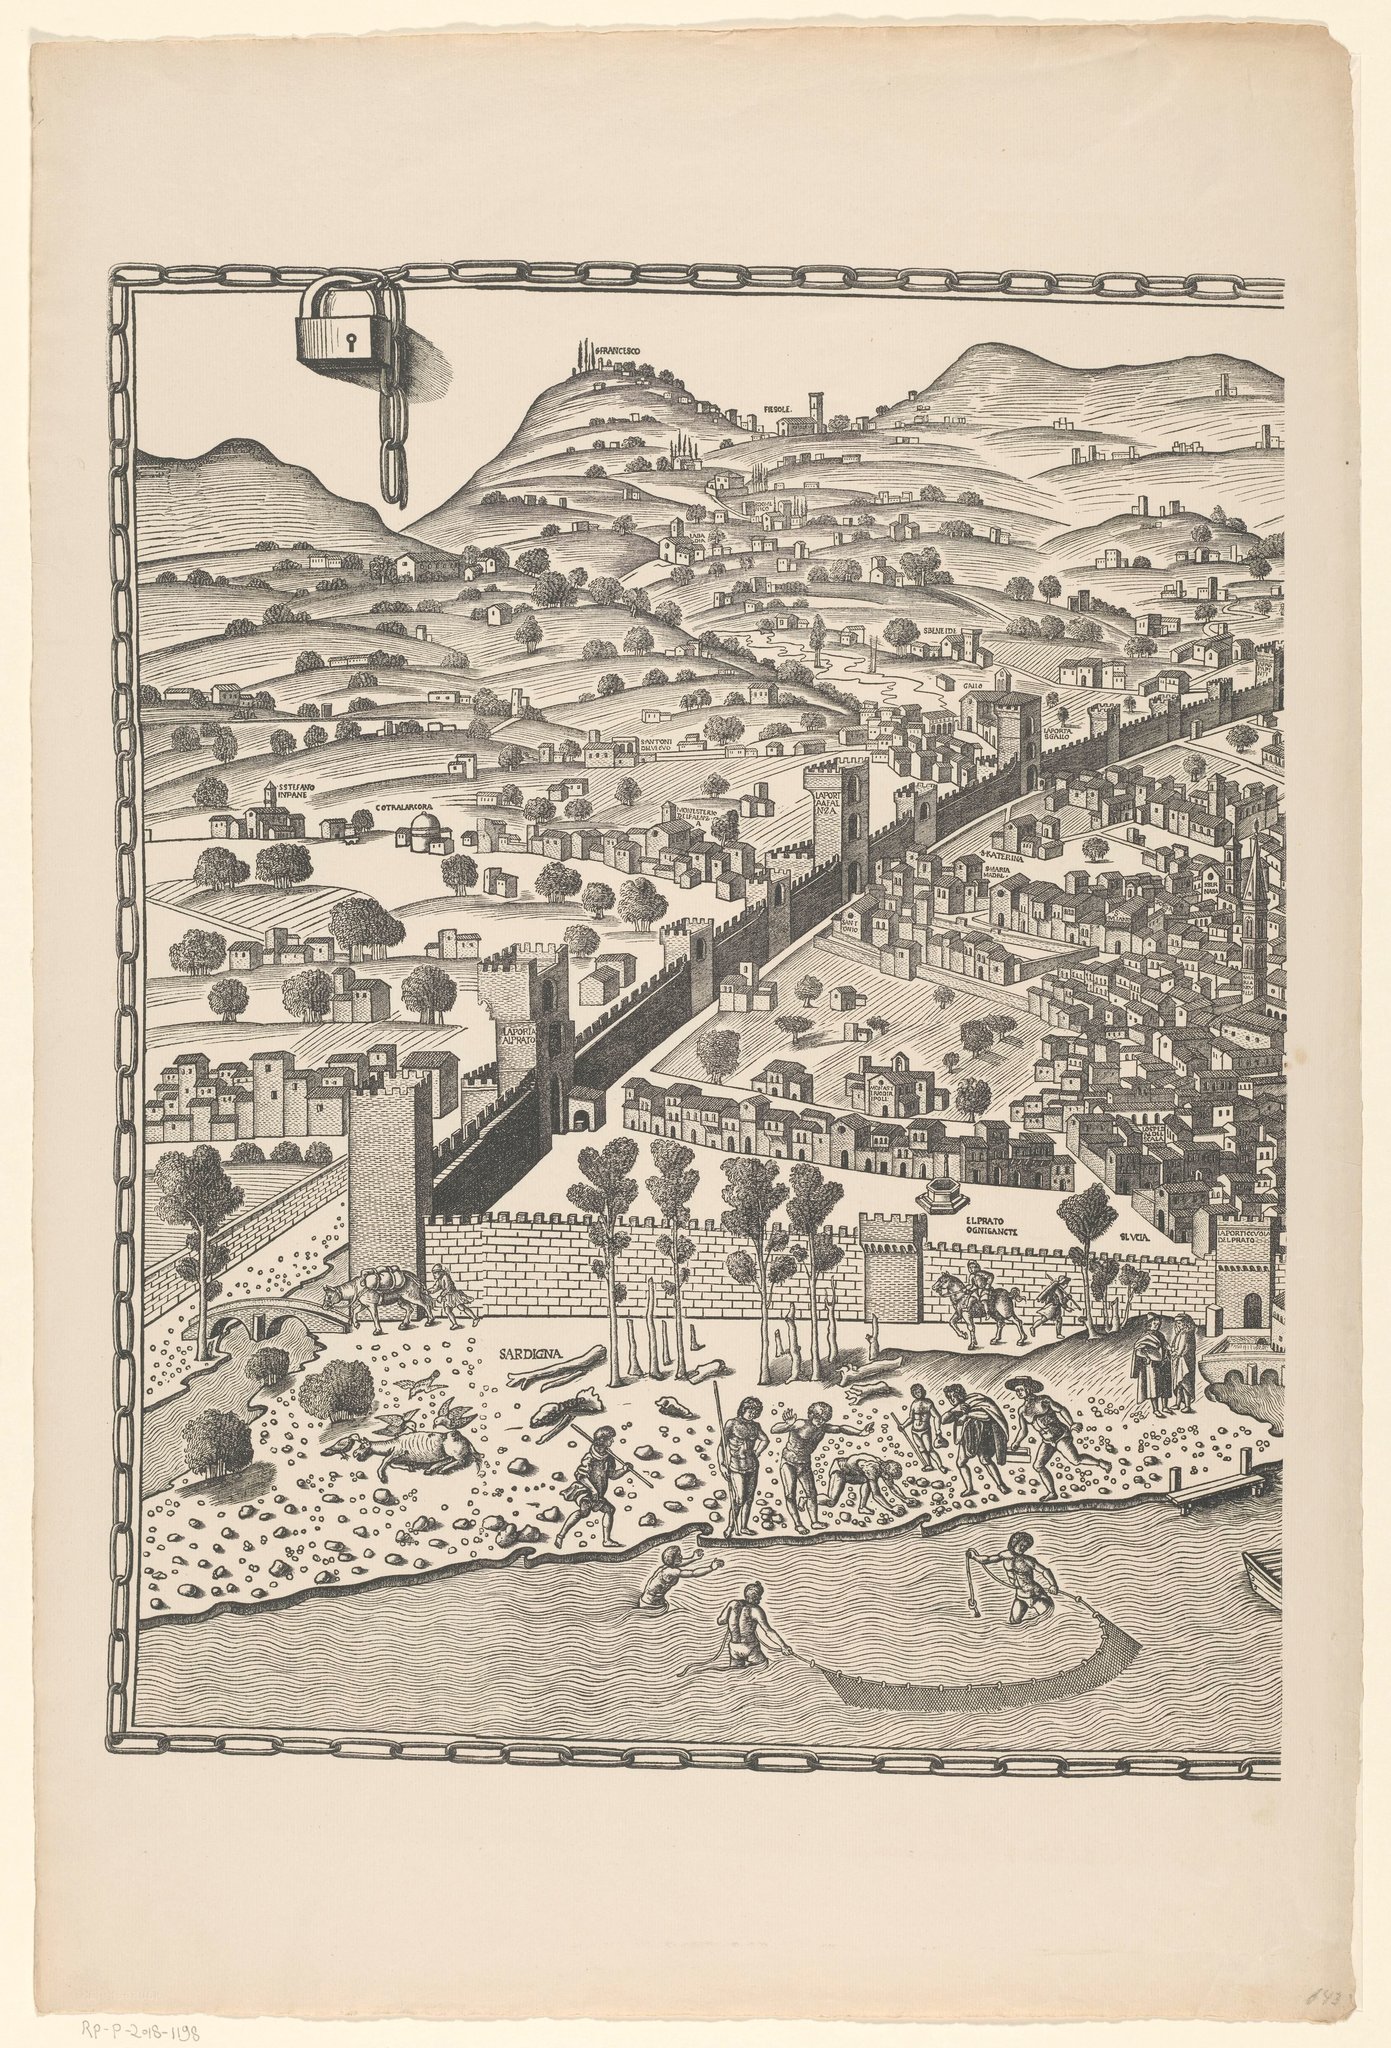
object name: photomechanical print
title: Fiorenza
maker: lucantonio degli uberti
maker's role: print maker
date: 1879-1949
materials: paper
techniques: photograph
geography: florence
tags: prospect of city, town panorama, silhouette of city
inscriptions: collector's mark: Lugt 4925, check stamp: ‘Reichsdruck’, collector's mark: Lugt 2228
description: Linkerdeel van een gezicht op Florence bestaande uit drie delen, ook wel de Pianta della Catena genoemd.